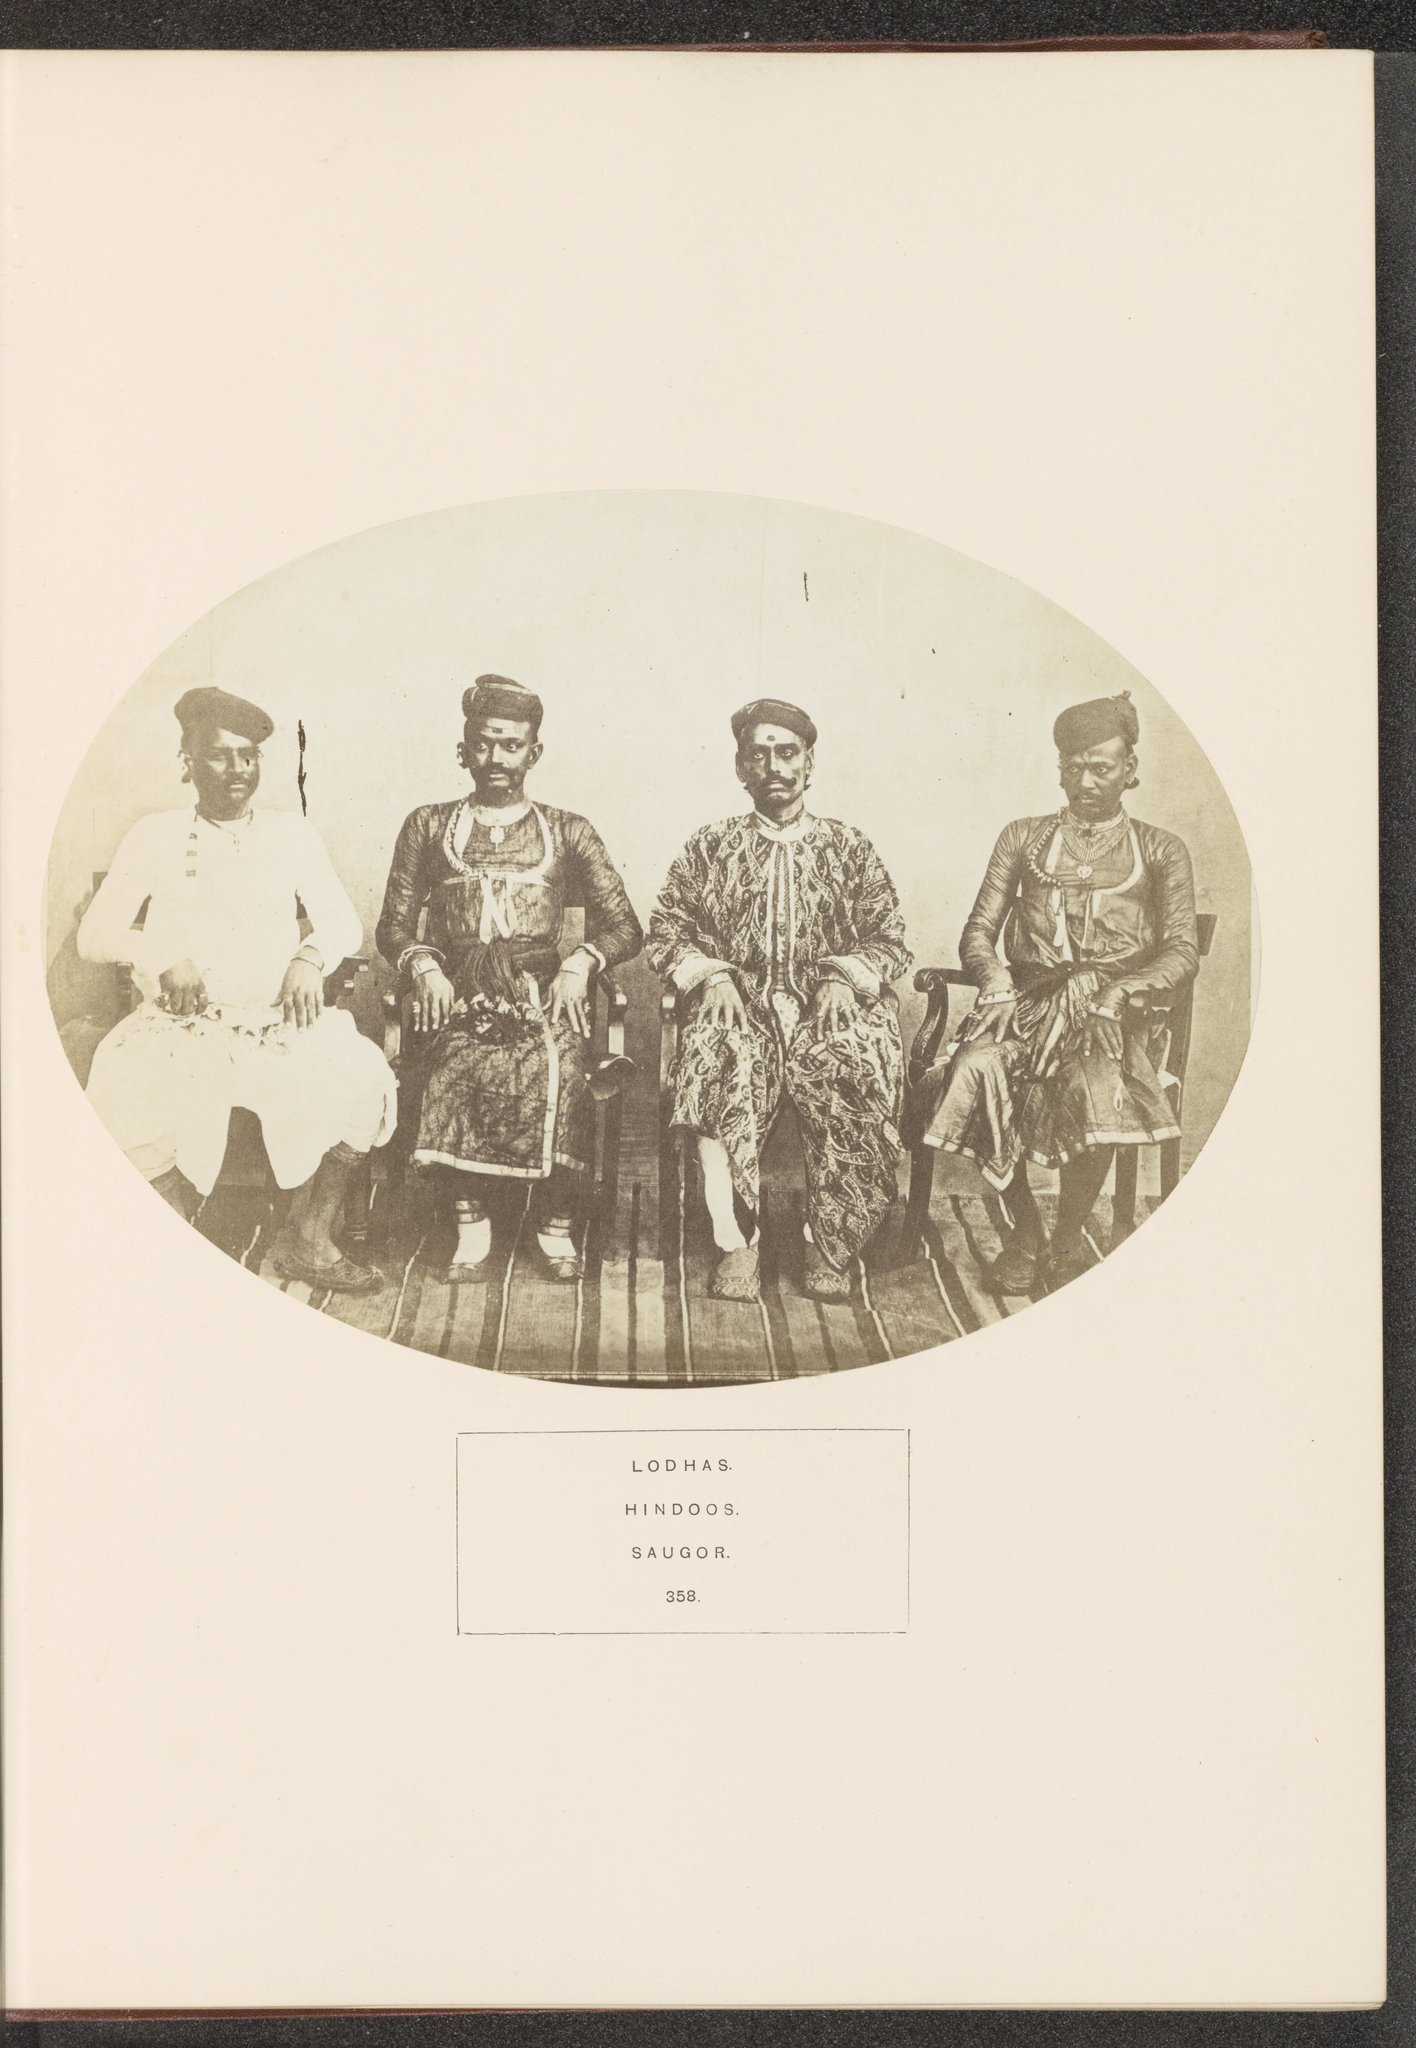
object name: page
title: Portrait of four unknown men from the Lodhi community of Sagar, Madhya Pradesh, India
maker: james john waterhouse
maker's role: fotograaf, luitenant, officier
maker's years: 1842-1928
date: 1862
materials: photographic support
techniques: albumen print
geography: sagar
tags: head-gear: turban, human races; peoples; nationalities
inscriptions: inscription: ‘LODHAS./ HINDOOS./ SAUGOR.’, number: ‘358.’